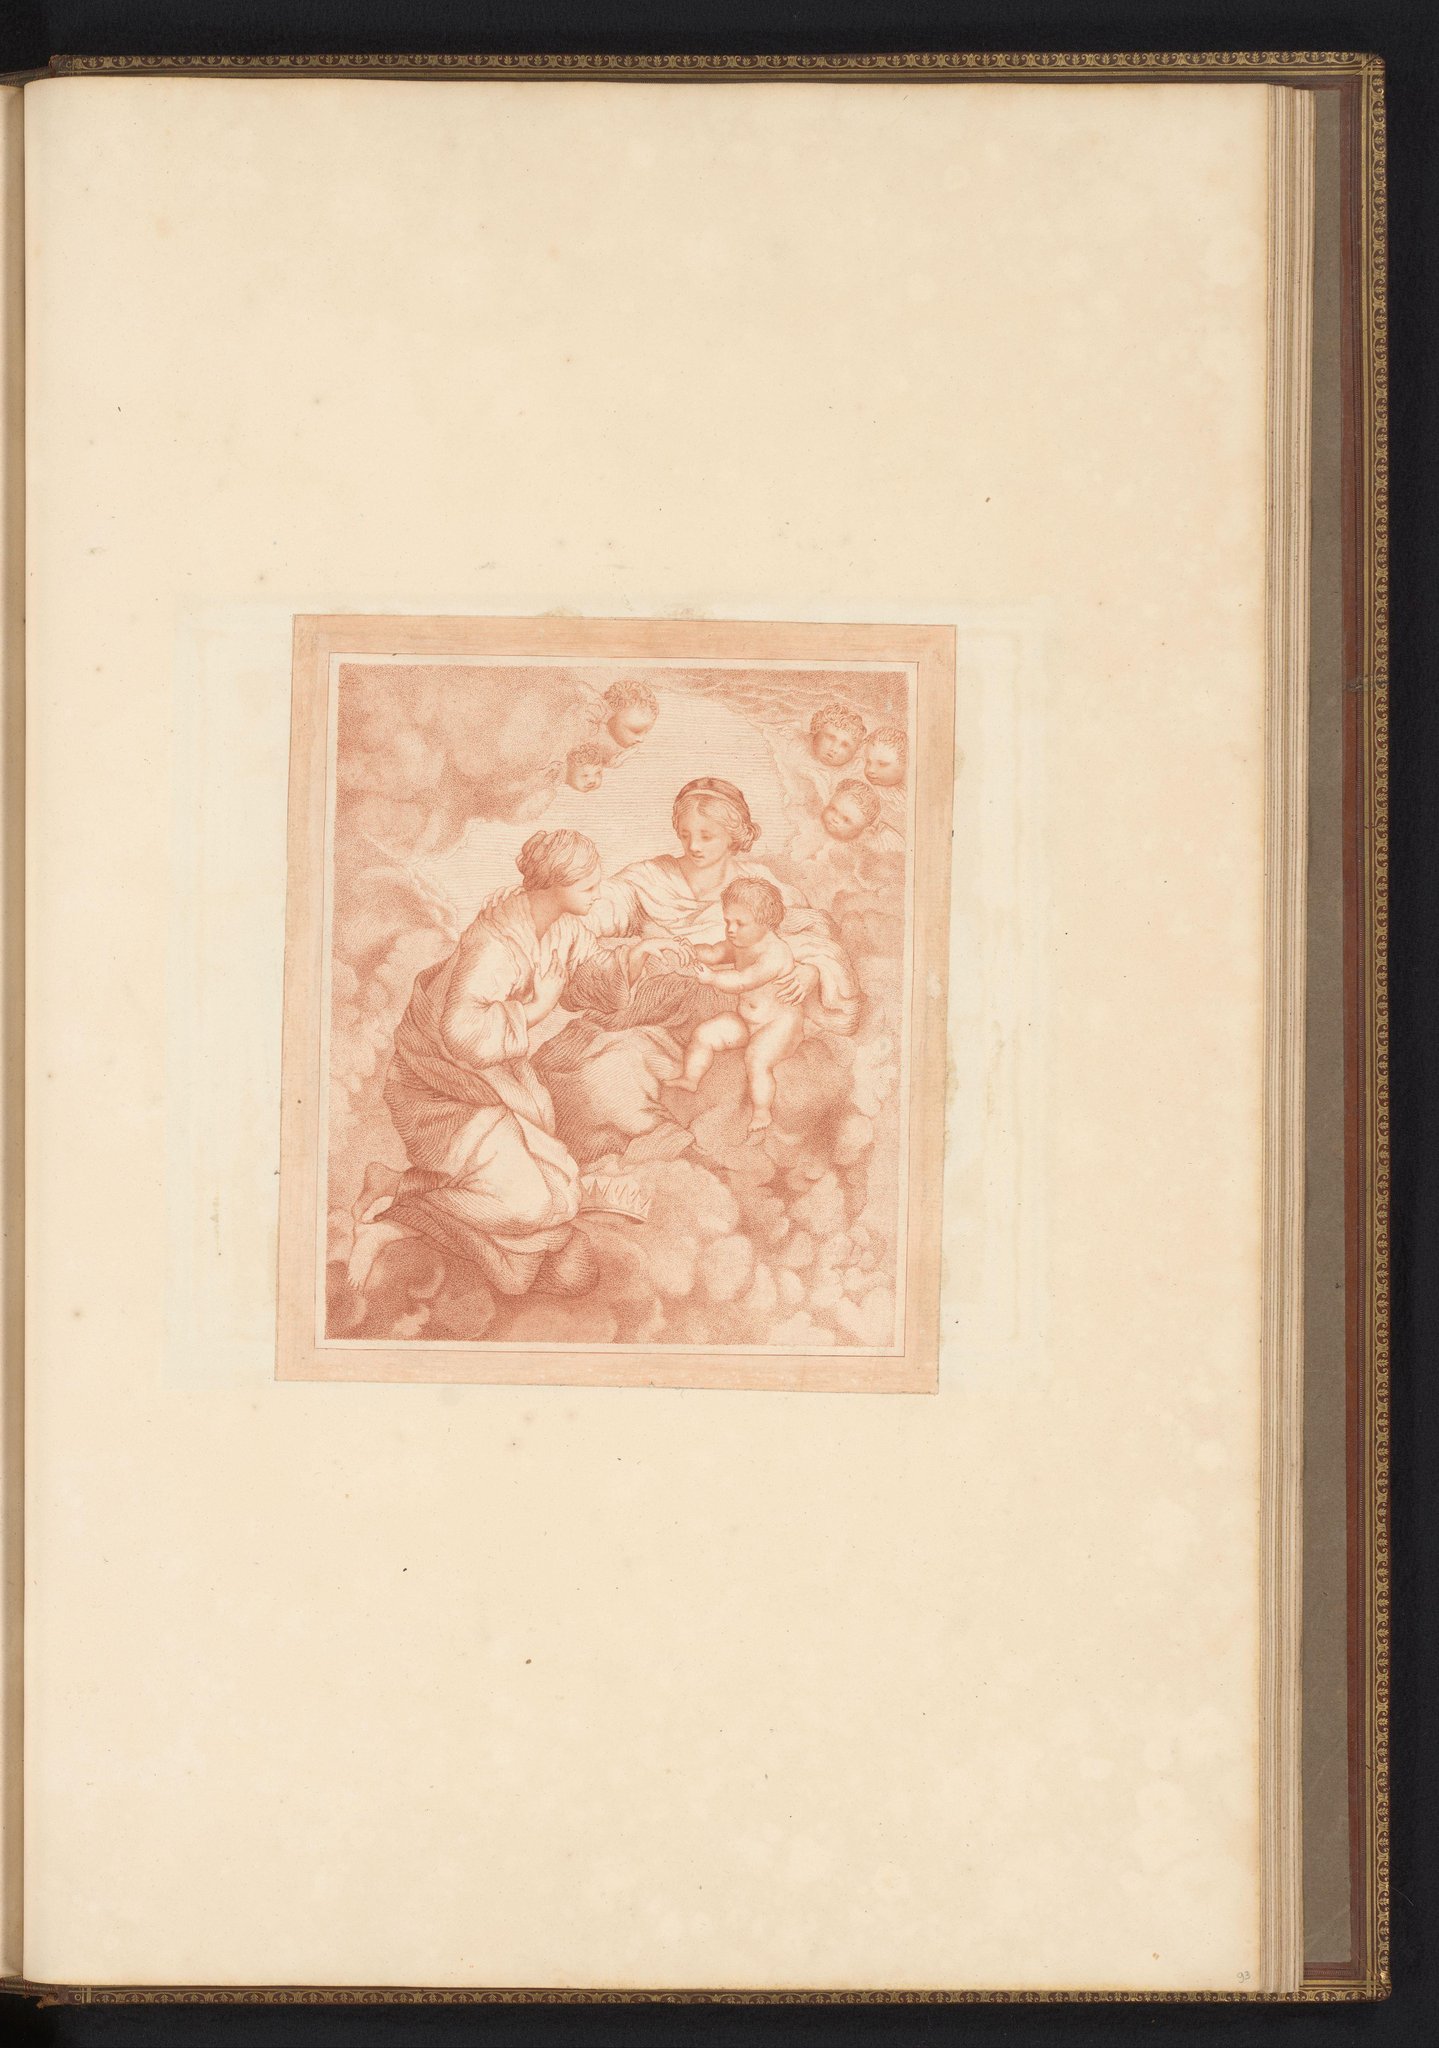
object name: album leaf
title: Mystieke huwelijk van Catherina van Alexandrië met het Christuskind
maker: william baillie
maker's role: print maker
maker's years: 1723-1810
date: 1753-1810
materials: paper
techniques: printmaking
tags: the mystic marriage of st. catherine of alexandria with the infant christ: the christ-child puts a ring on her finger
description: De maagd Maria met één hand op de schouders van de heilige Catharina van Alexandrië en haar andere hand om de middel van het Christuskind. Hij schuift een ring aan de vinger van Catharina. De prent maakt deel uit van een album.